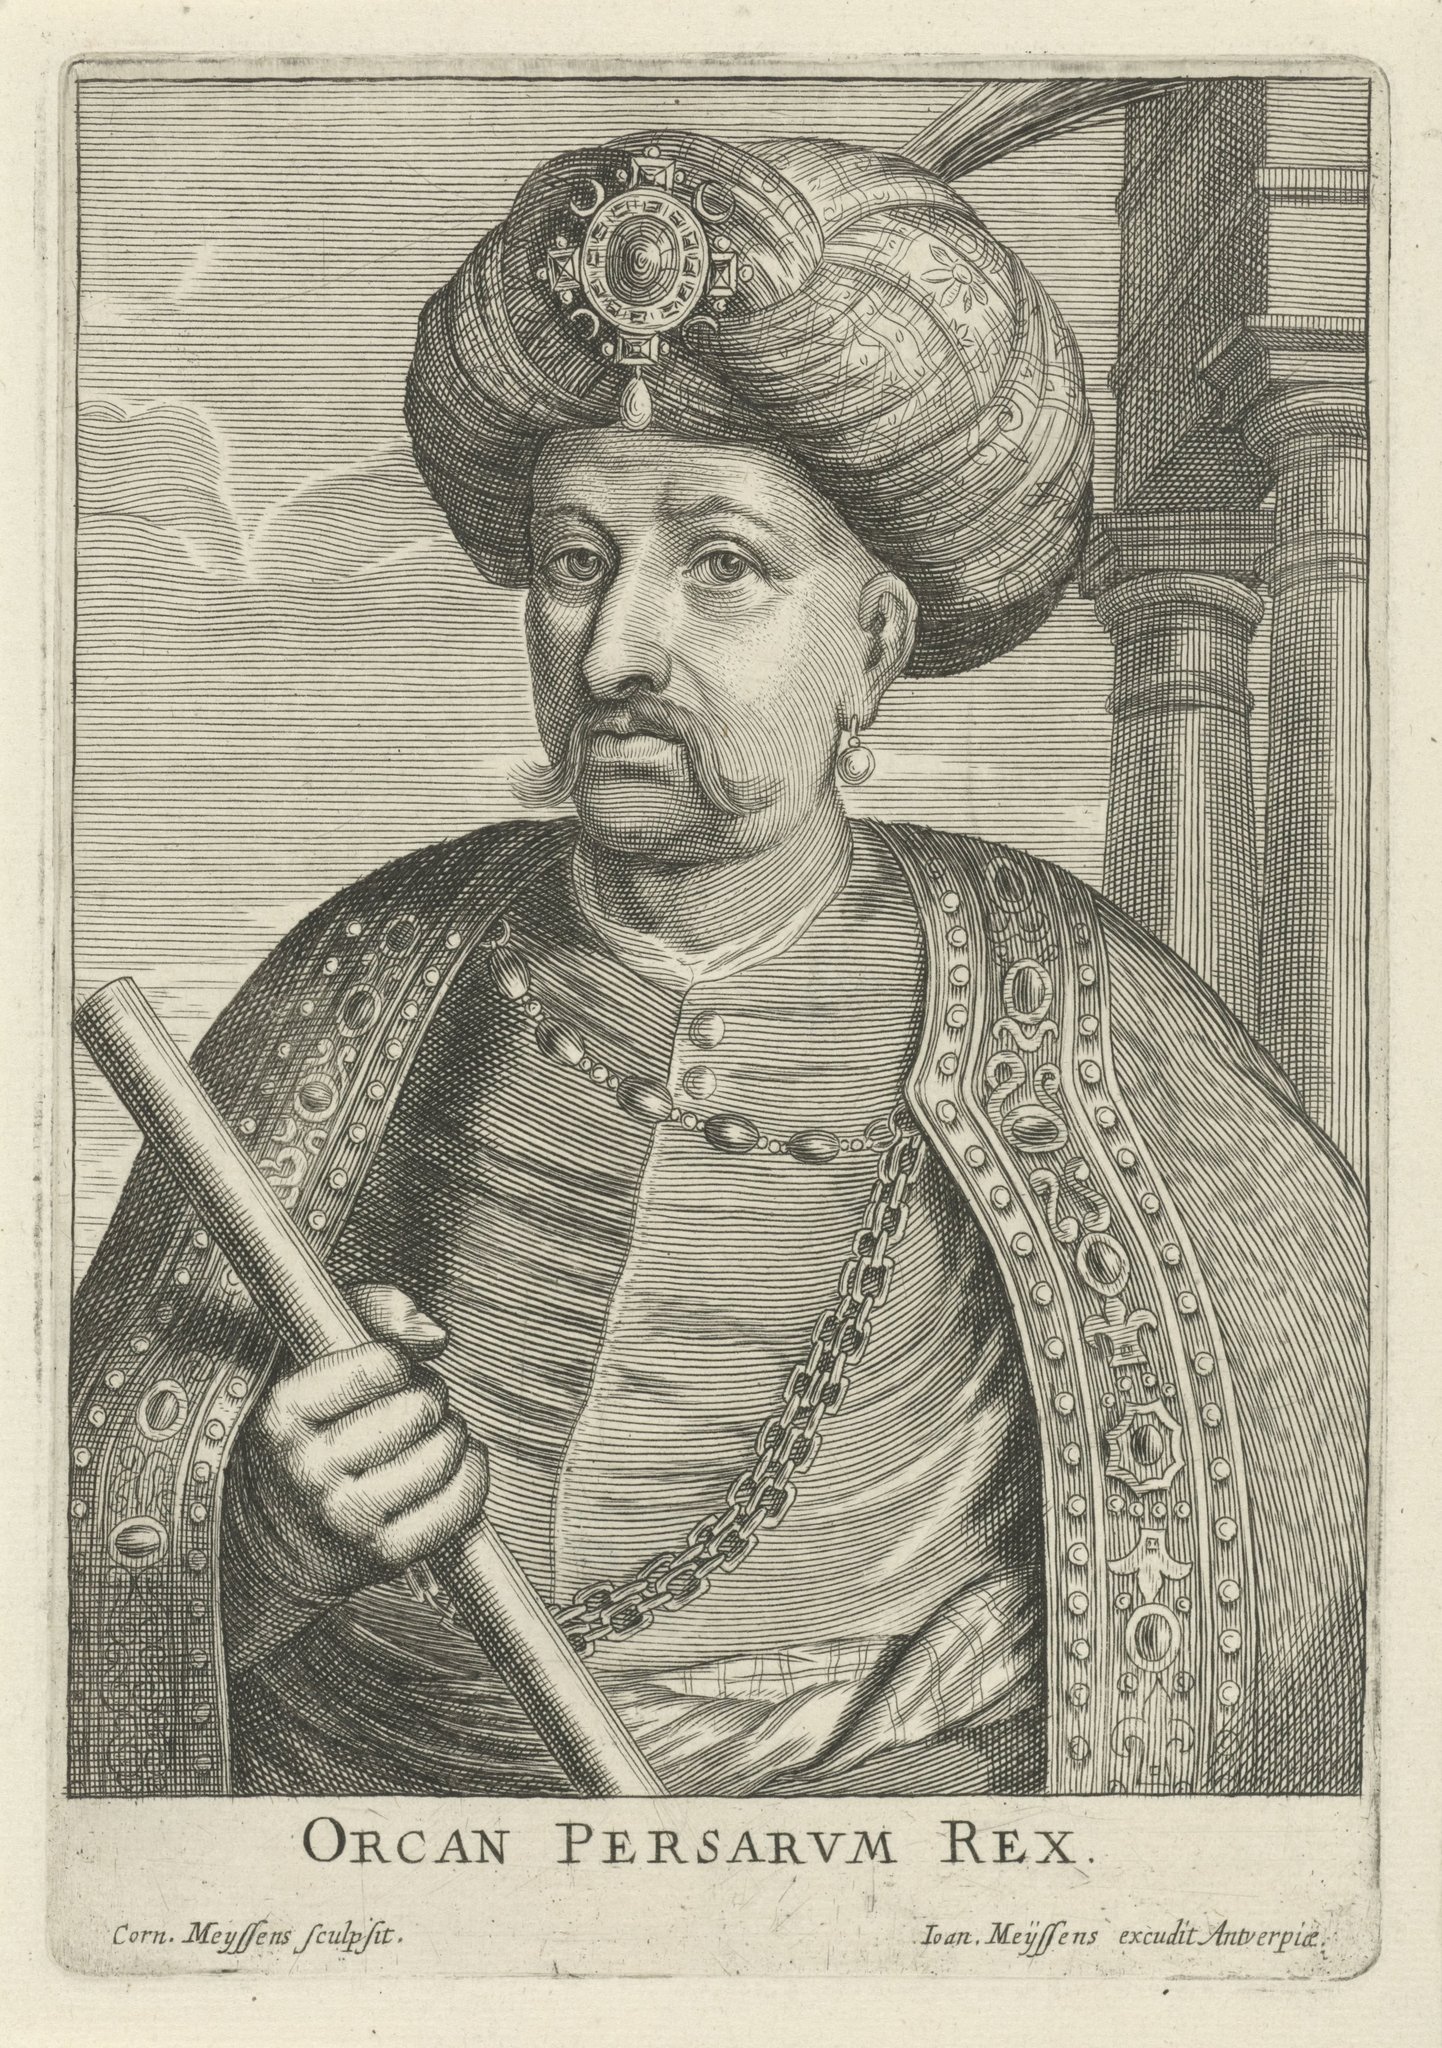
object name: print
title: Portret van Orcan Persarum Rex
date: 1650-1670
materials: paper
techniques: engraving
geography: antwerp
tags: head-gear: turban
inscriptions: collector's mark: Lugt 2228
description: Portret van Orcan Persarum Rex, met een bevelhebberstaf in zijn hand en een tulband op zijn hoofd.